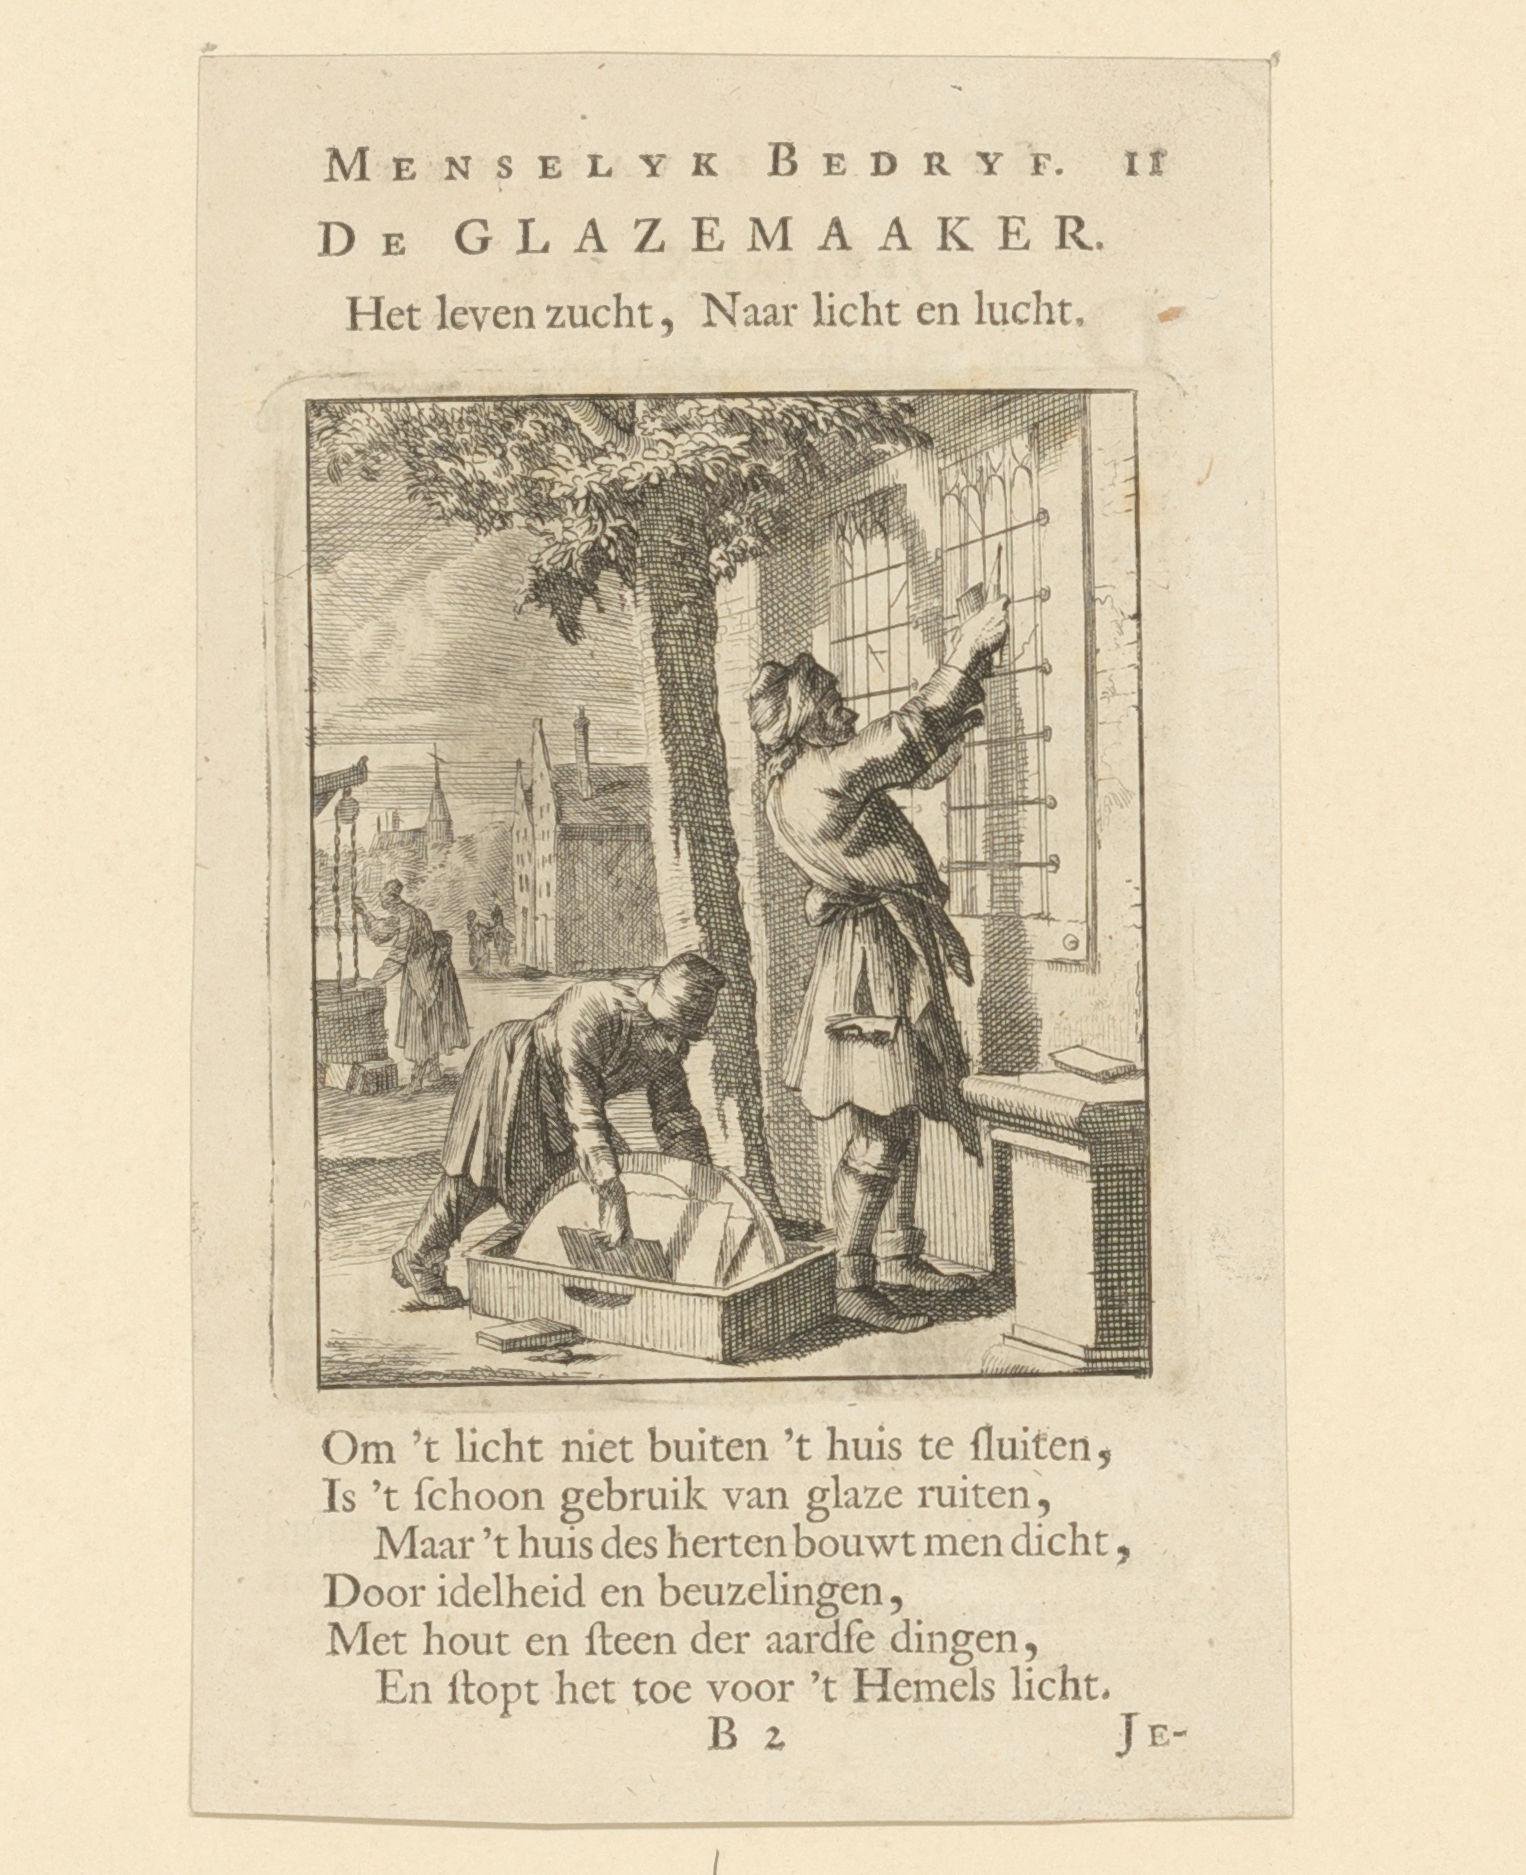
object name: print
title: De Glazenmaaker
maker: cornelis van der sys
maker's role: publisher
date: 1718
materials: paper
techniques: etching, letterpress printing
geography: amsterdam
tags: handicrafts, craftsman at work, glass-maker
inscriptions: stamp, collector's mark: Lugt 1641, stamp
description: Prent oorspronkelijk verschenen in de 100-delige serie beroepsprenten van Jan en Caspar Luyken, getiteld: Het menselyk bedryf. S.l.s.n., 1694 (eerste druk). Daarna is de titel en het vers afgesneden. De prenten in diverse publicaties verschenen en gekopieerd. Huidige staat uit: Luyken, Jan en Caspar. Spiegel van het menselyk bedryf (...). Amsterdam: Cornelis van der Sys, 1718, p. 11. Prent waarschijnlijk ook gebruikt in eerdere (1704) en latere (1730, 1749, 1767) publicaties.